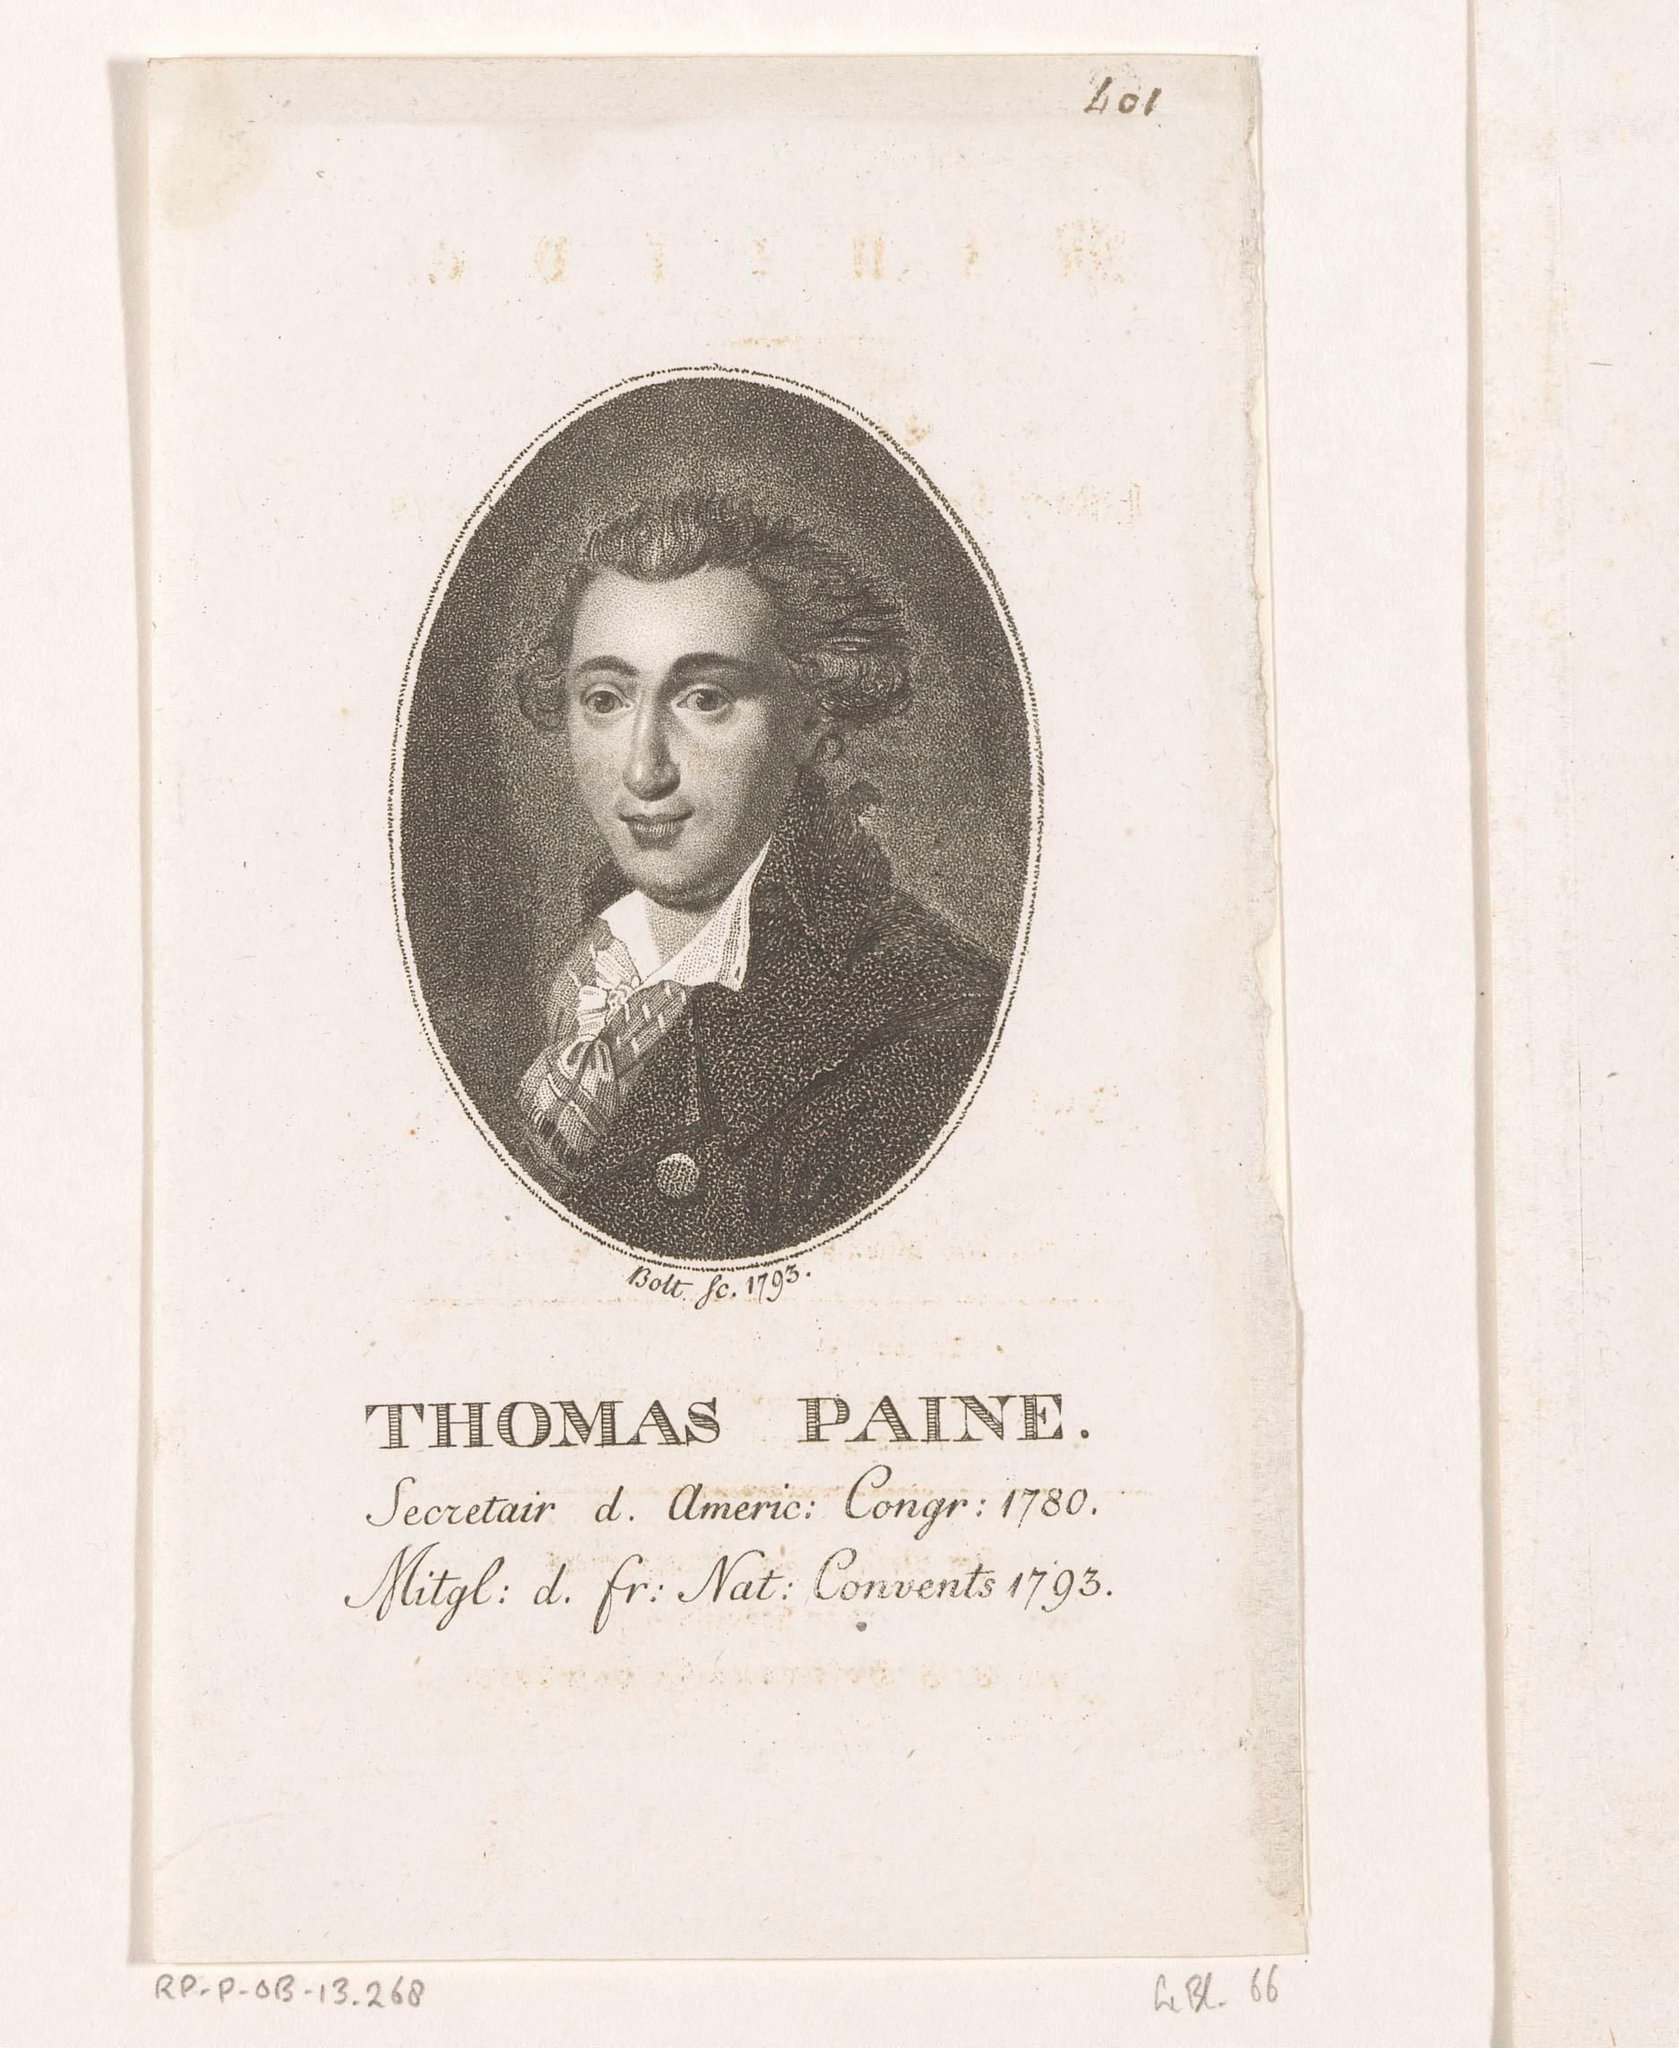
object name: print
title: Portret van Thomas Paine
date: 1793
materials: paper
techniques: stippling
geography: hamburg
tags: new york (city), historical persons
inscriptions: date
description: Prent afkomstig uit: Minerva. Ein Journal historischen und politischen Inhalt [uitgegeven door:] Johann Wilhelm Archenholz. Erster Band. April, May, Juny 1793. Hamburg: Johann Wilhelm Archenholz en Benjamin Gottlob Hoffmann, [1793].